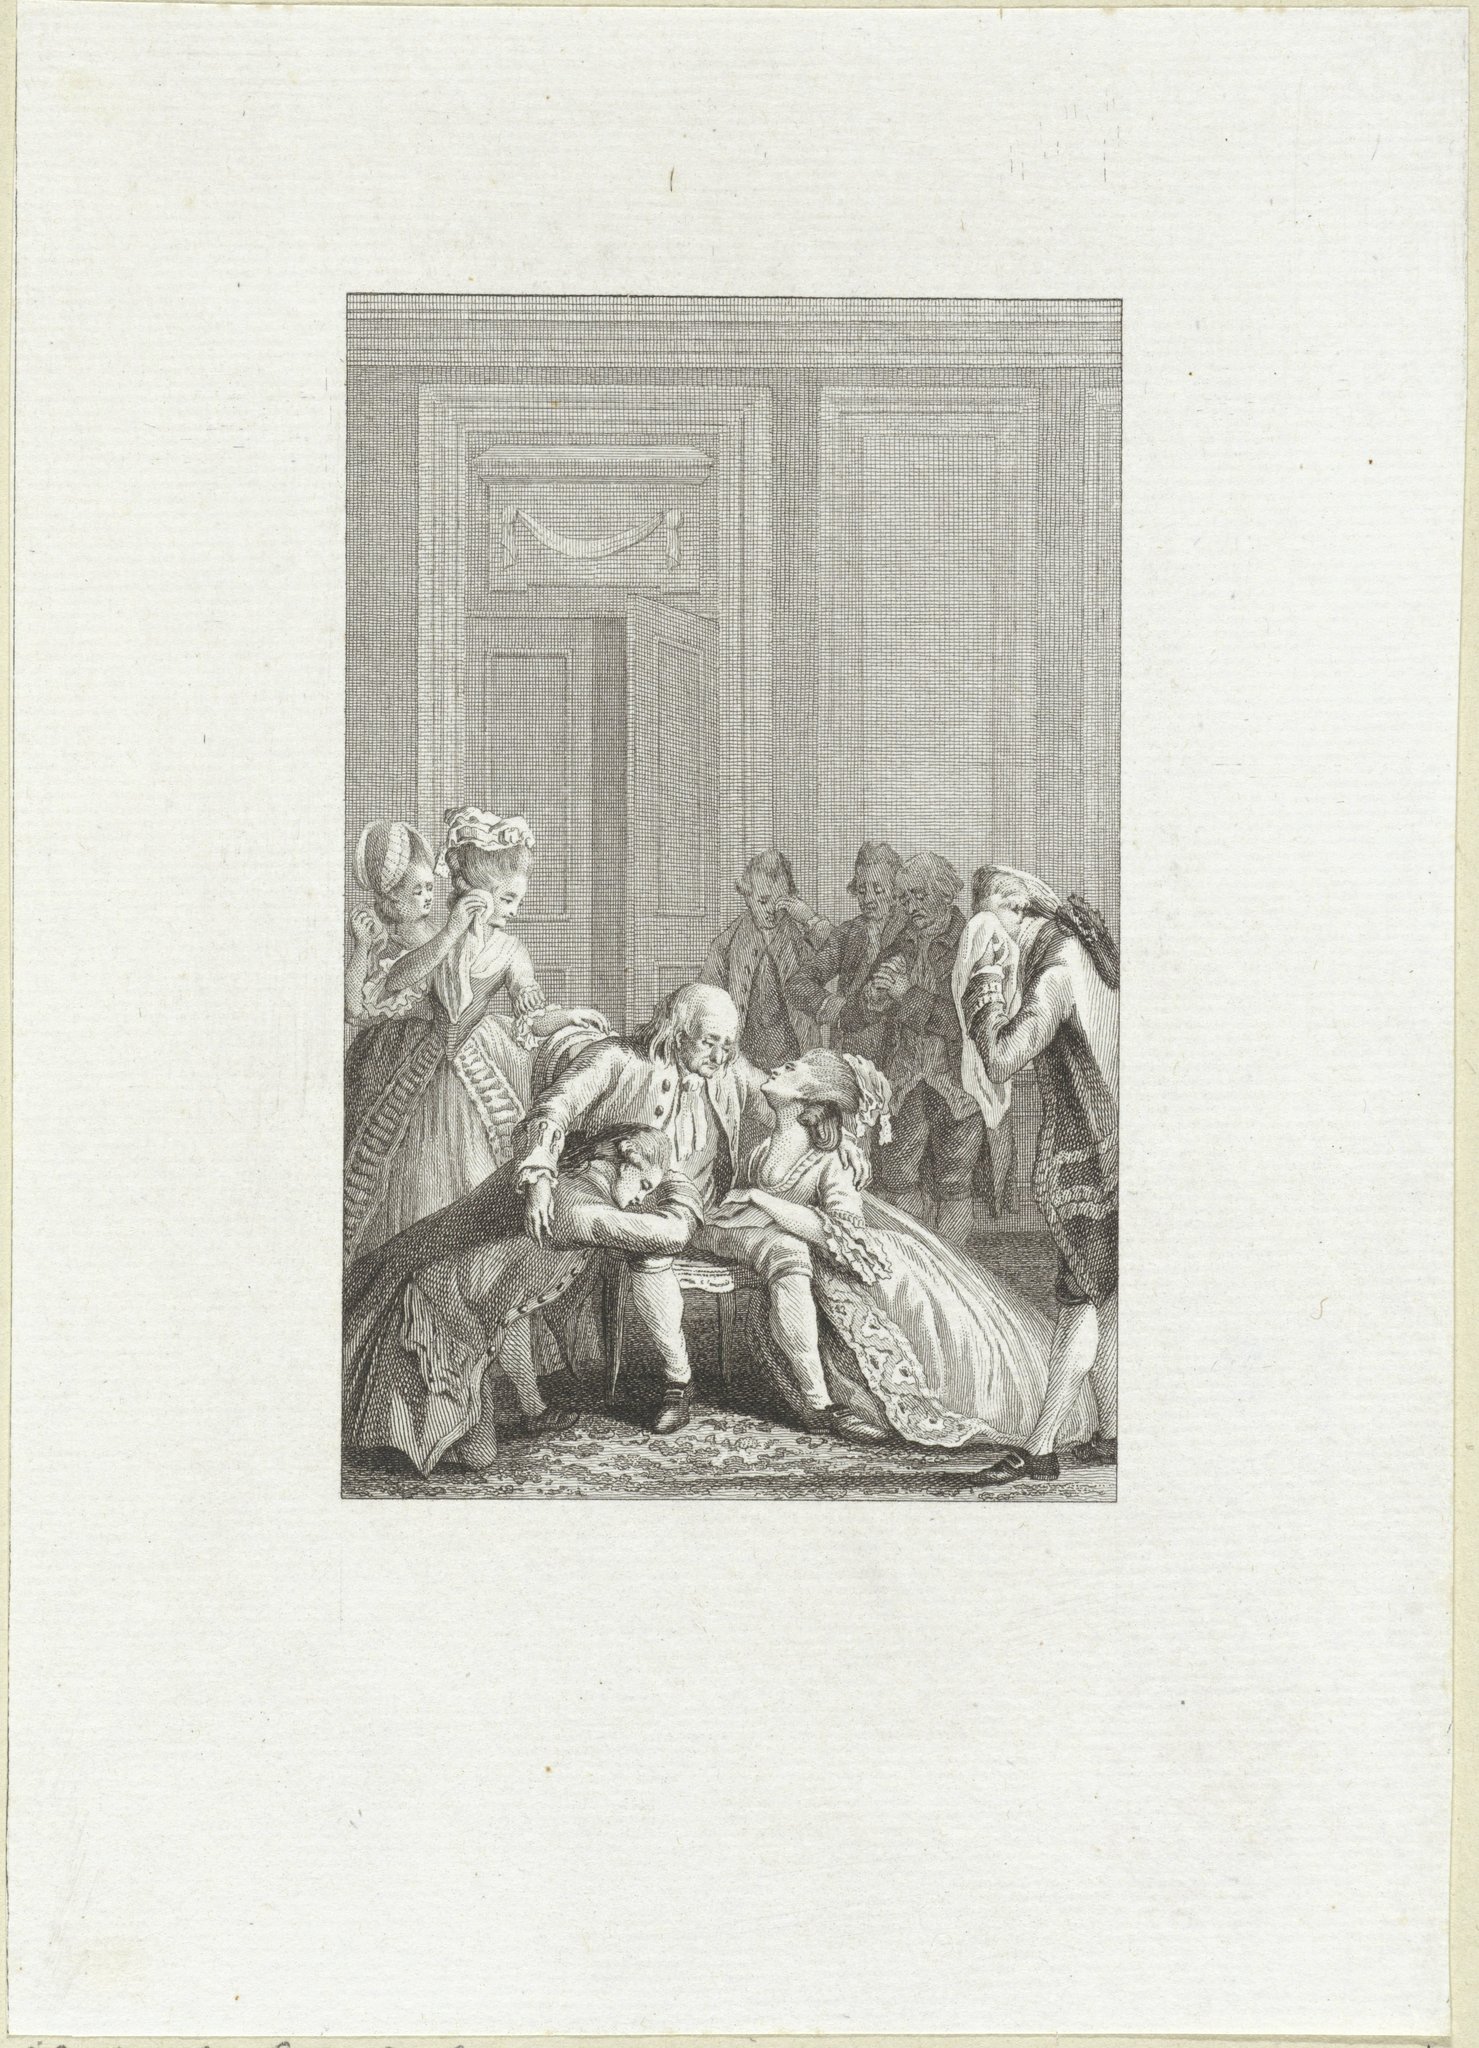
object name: print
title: Vertrek vol huilende mensen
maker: reinier vinkeles (i)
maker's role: draughtsman, print maker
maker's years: 1741-1816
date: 1779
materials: paper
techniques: engraving, etching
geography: amsterdam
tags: handkerchief, weeping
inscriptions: collector's mark: Lugt 240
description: Proefdruk van een illustratie voor het toneelstuk 'De Natuurlijke Zoon'.